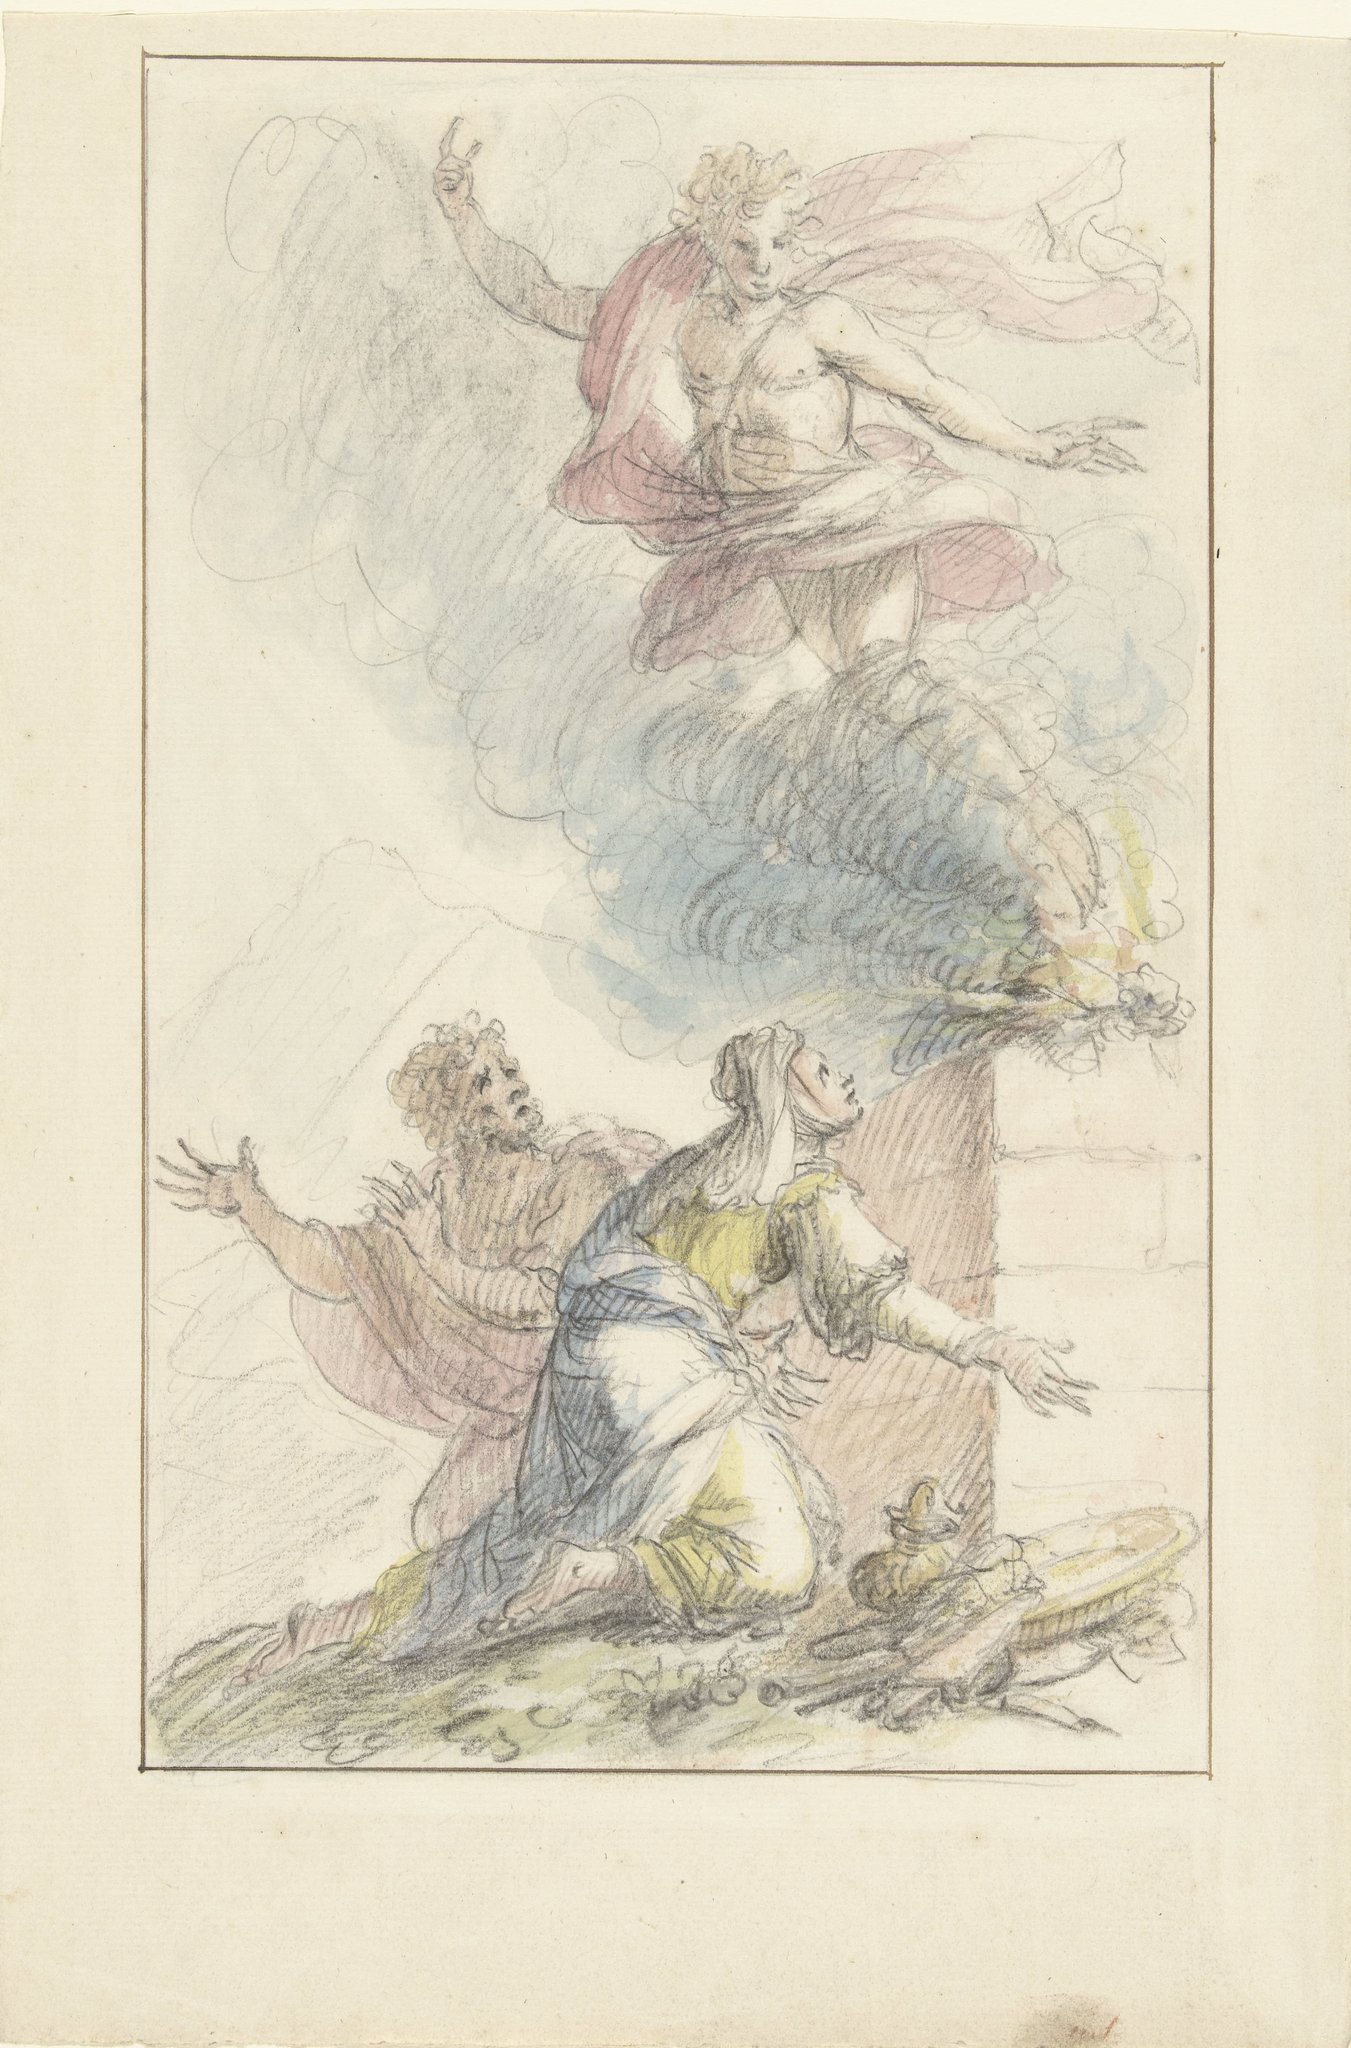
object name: drawing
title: Het offer van Manoach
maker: elias van nijmegen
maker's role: draughtsman, painter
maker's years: 1667-1755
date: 1677-1755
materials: chalk, paper, pencil, watercolor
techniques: brush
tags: manoah's sacrifice; the angel ascends in the flames